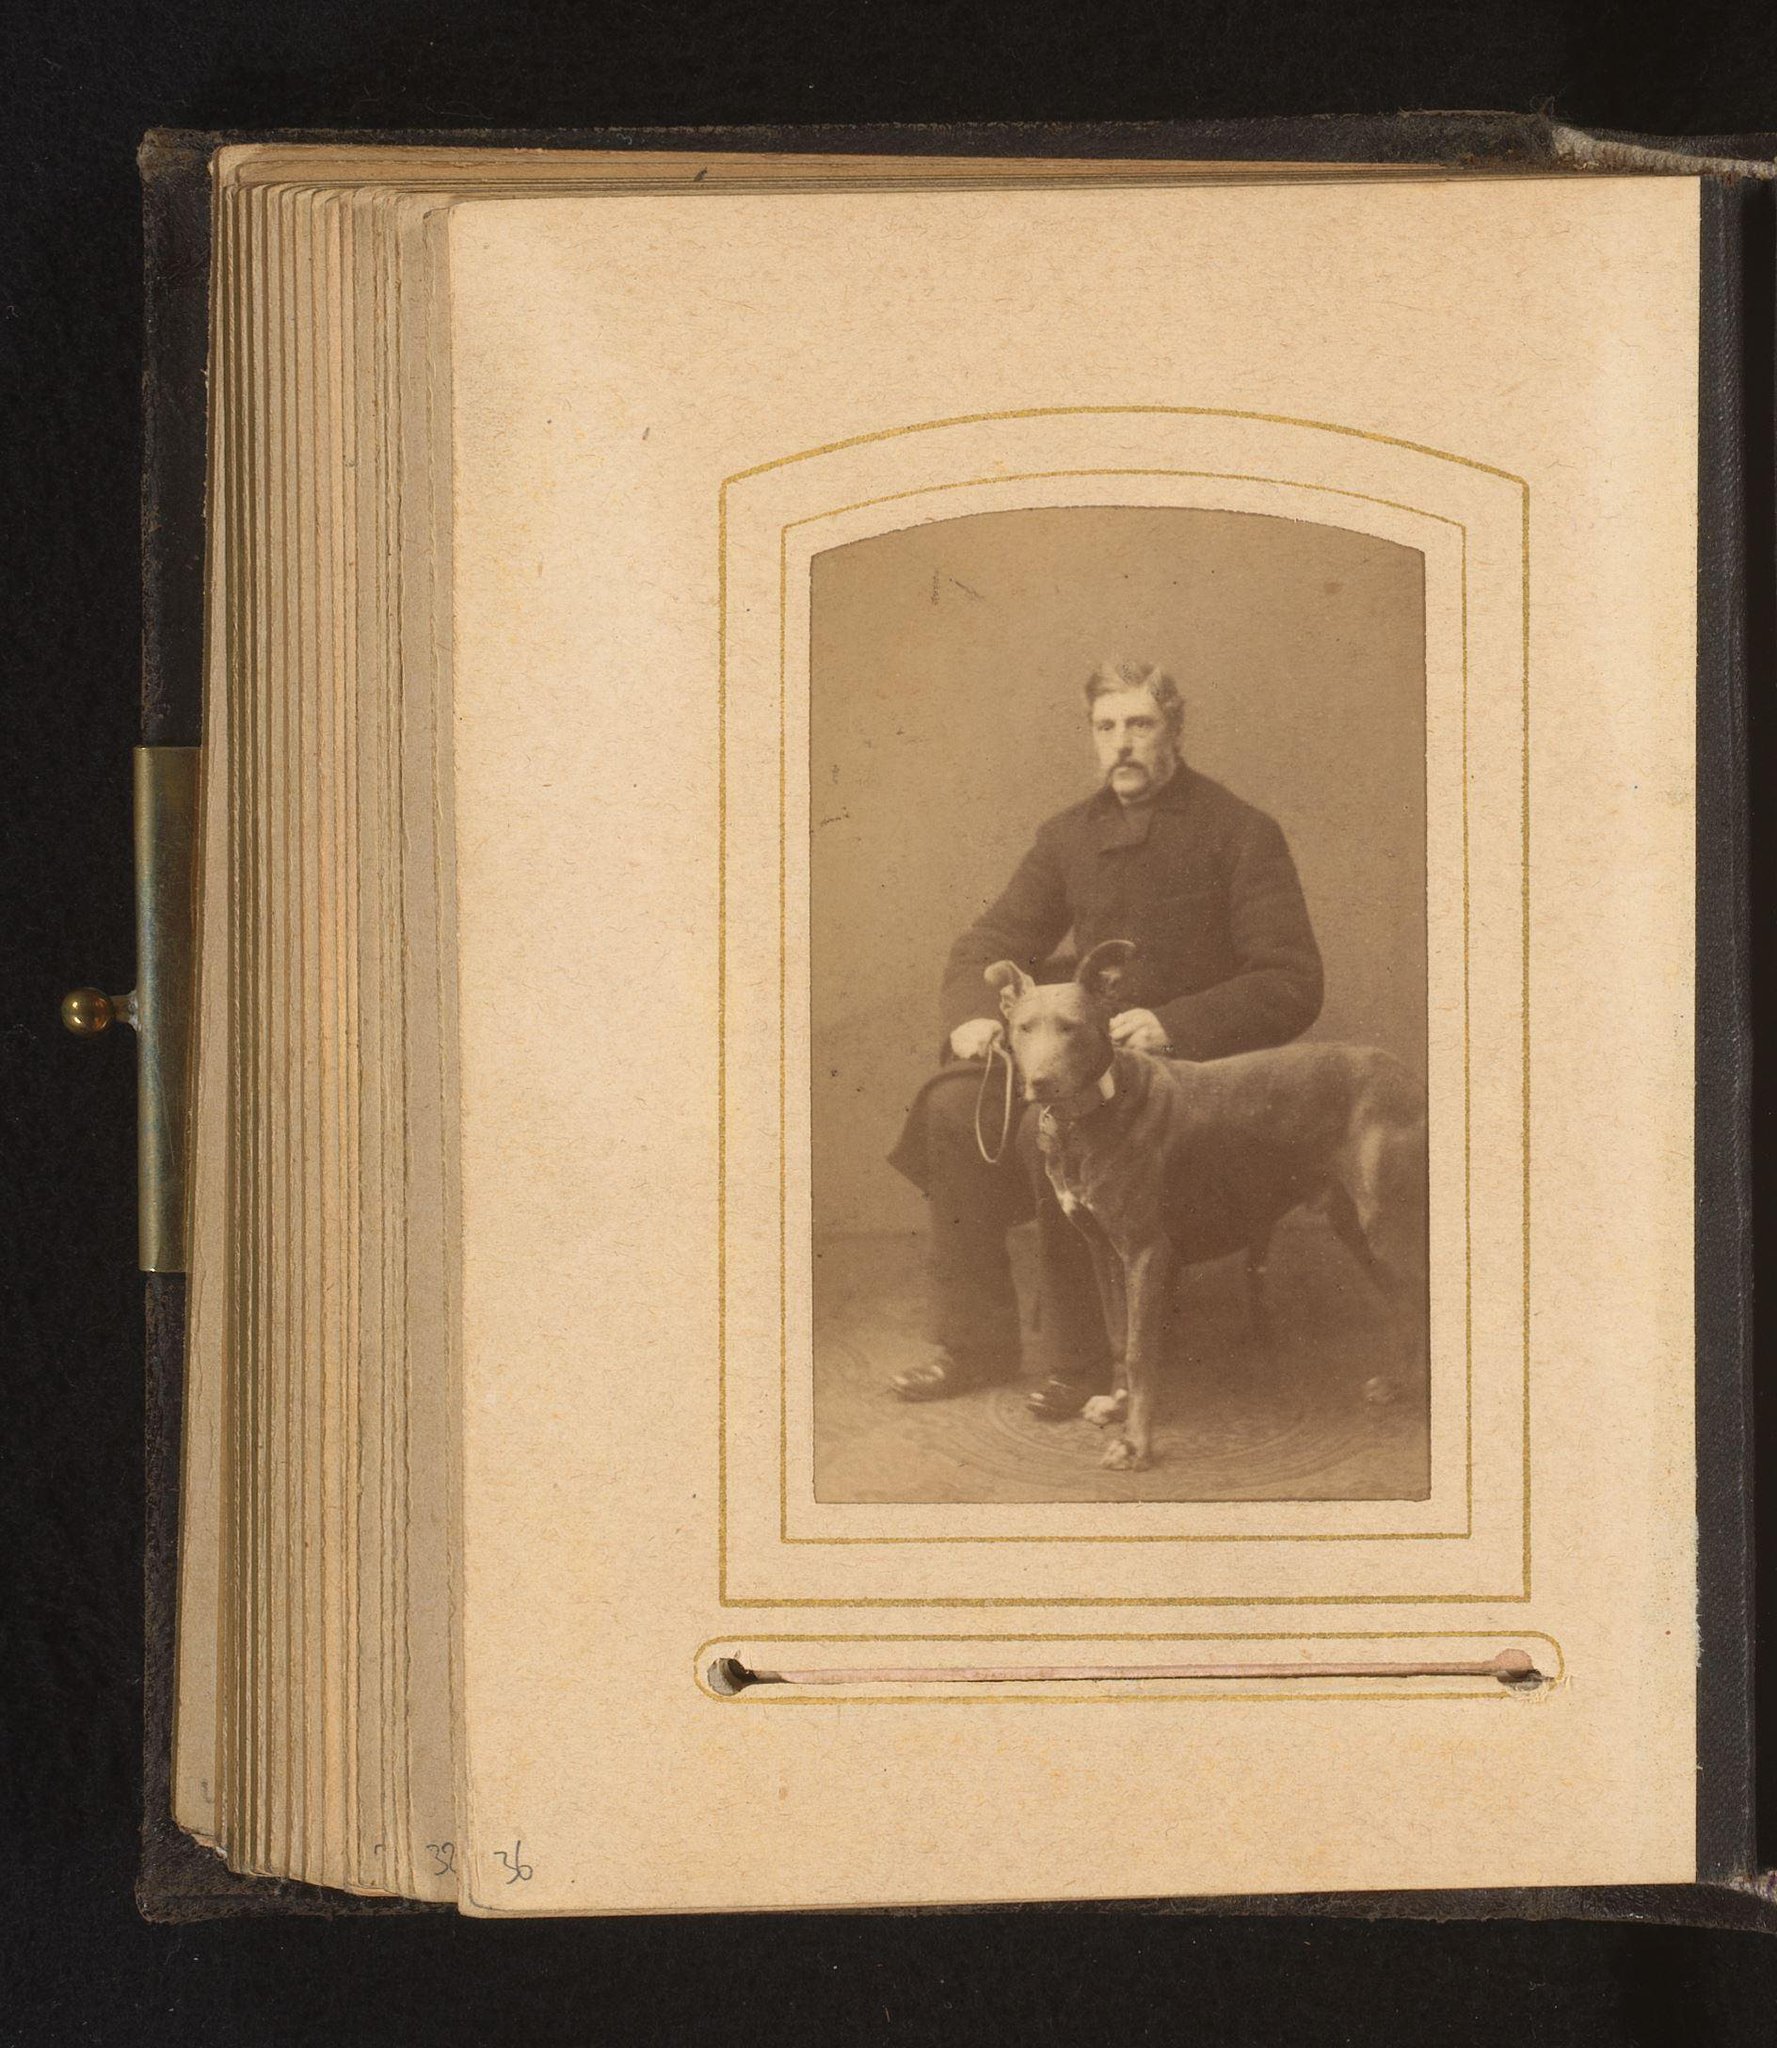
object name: carte de visite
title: Portret van een zittende man met hond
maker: jan george mulder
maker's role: fotograaf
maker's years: 1816-1895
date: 1865-1887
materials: cardboard, photographic support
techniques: albumen print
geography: haarlem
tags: historical persons, dog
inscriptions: inscription: ‘Photographie/ J.G. Mulder te Haarlem/ Lange Begijnestraat No.12/ over de Israëlitische Kerk’